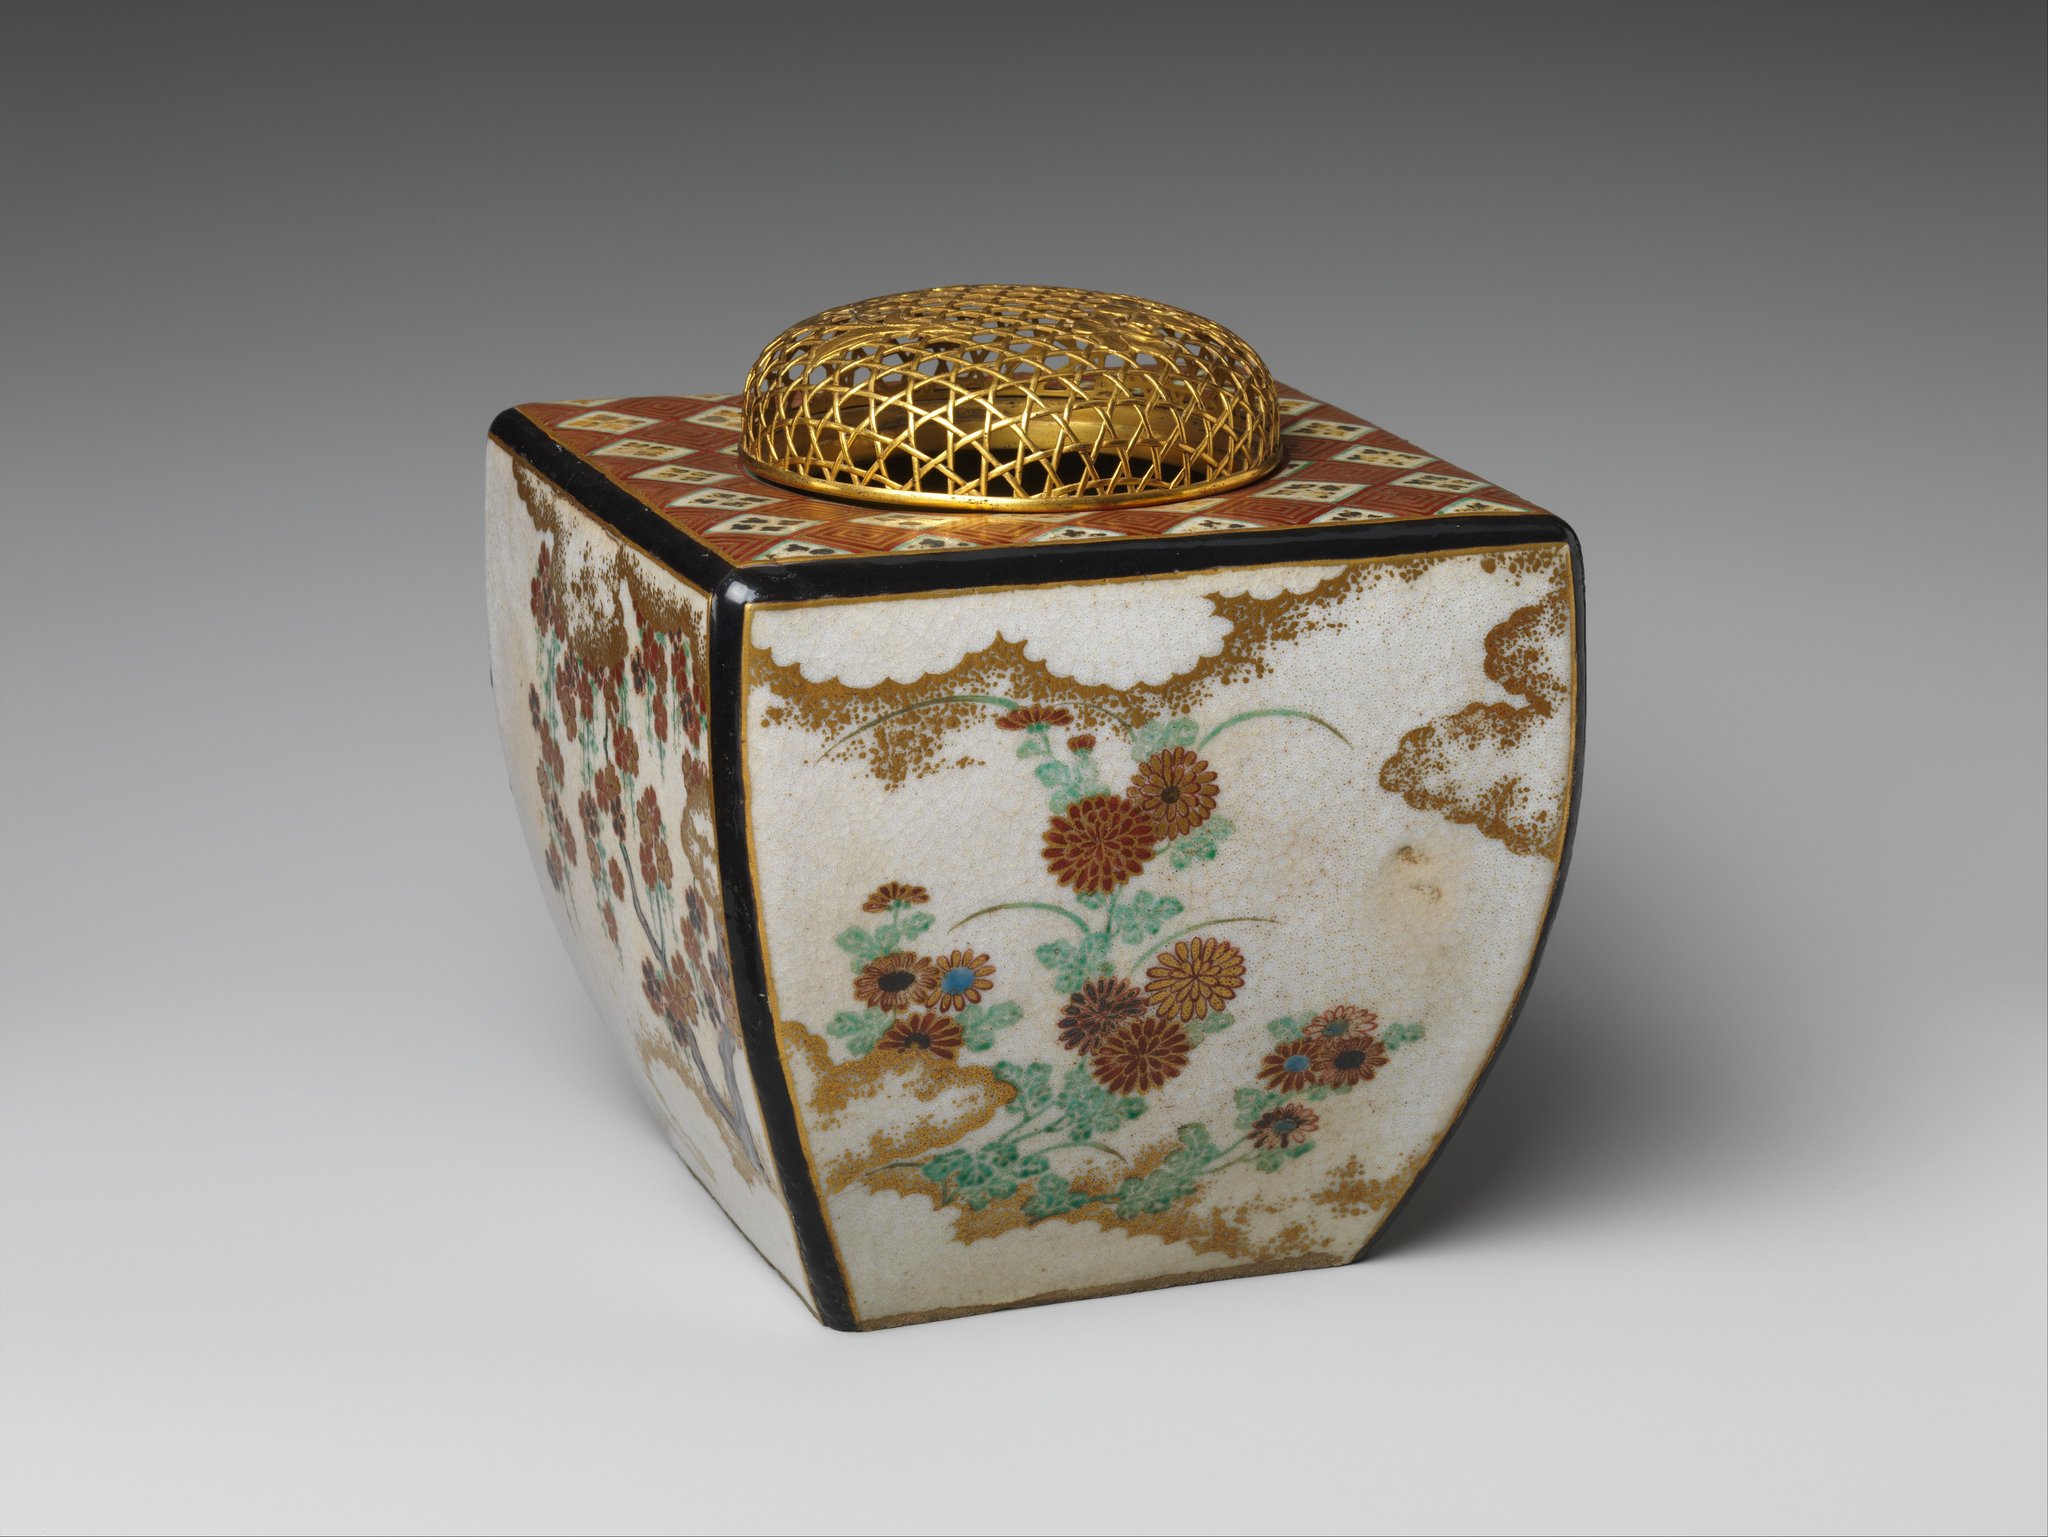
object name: incense burner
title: Ninsei-style Incense Burner with Flowers of the Four Seasons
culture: japanese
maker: nonomura ninsei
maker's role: artist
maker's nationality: japanese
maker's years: 1646-1694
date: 1601-1700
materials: enamel, gilt bronze, gold, stoneware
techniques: overglaze, polychrome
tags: flowers